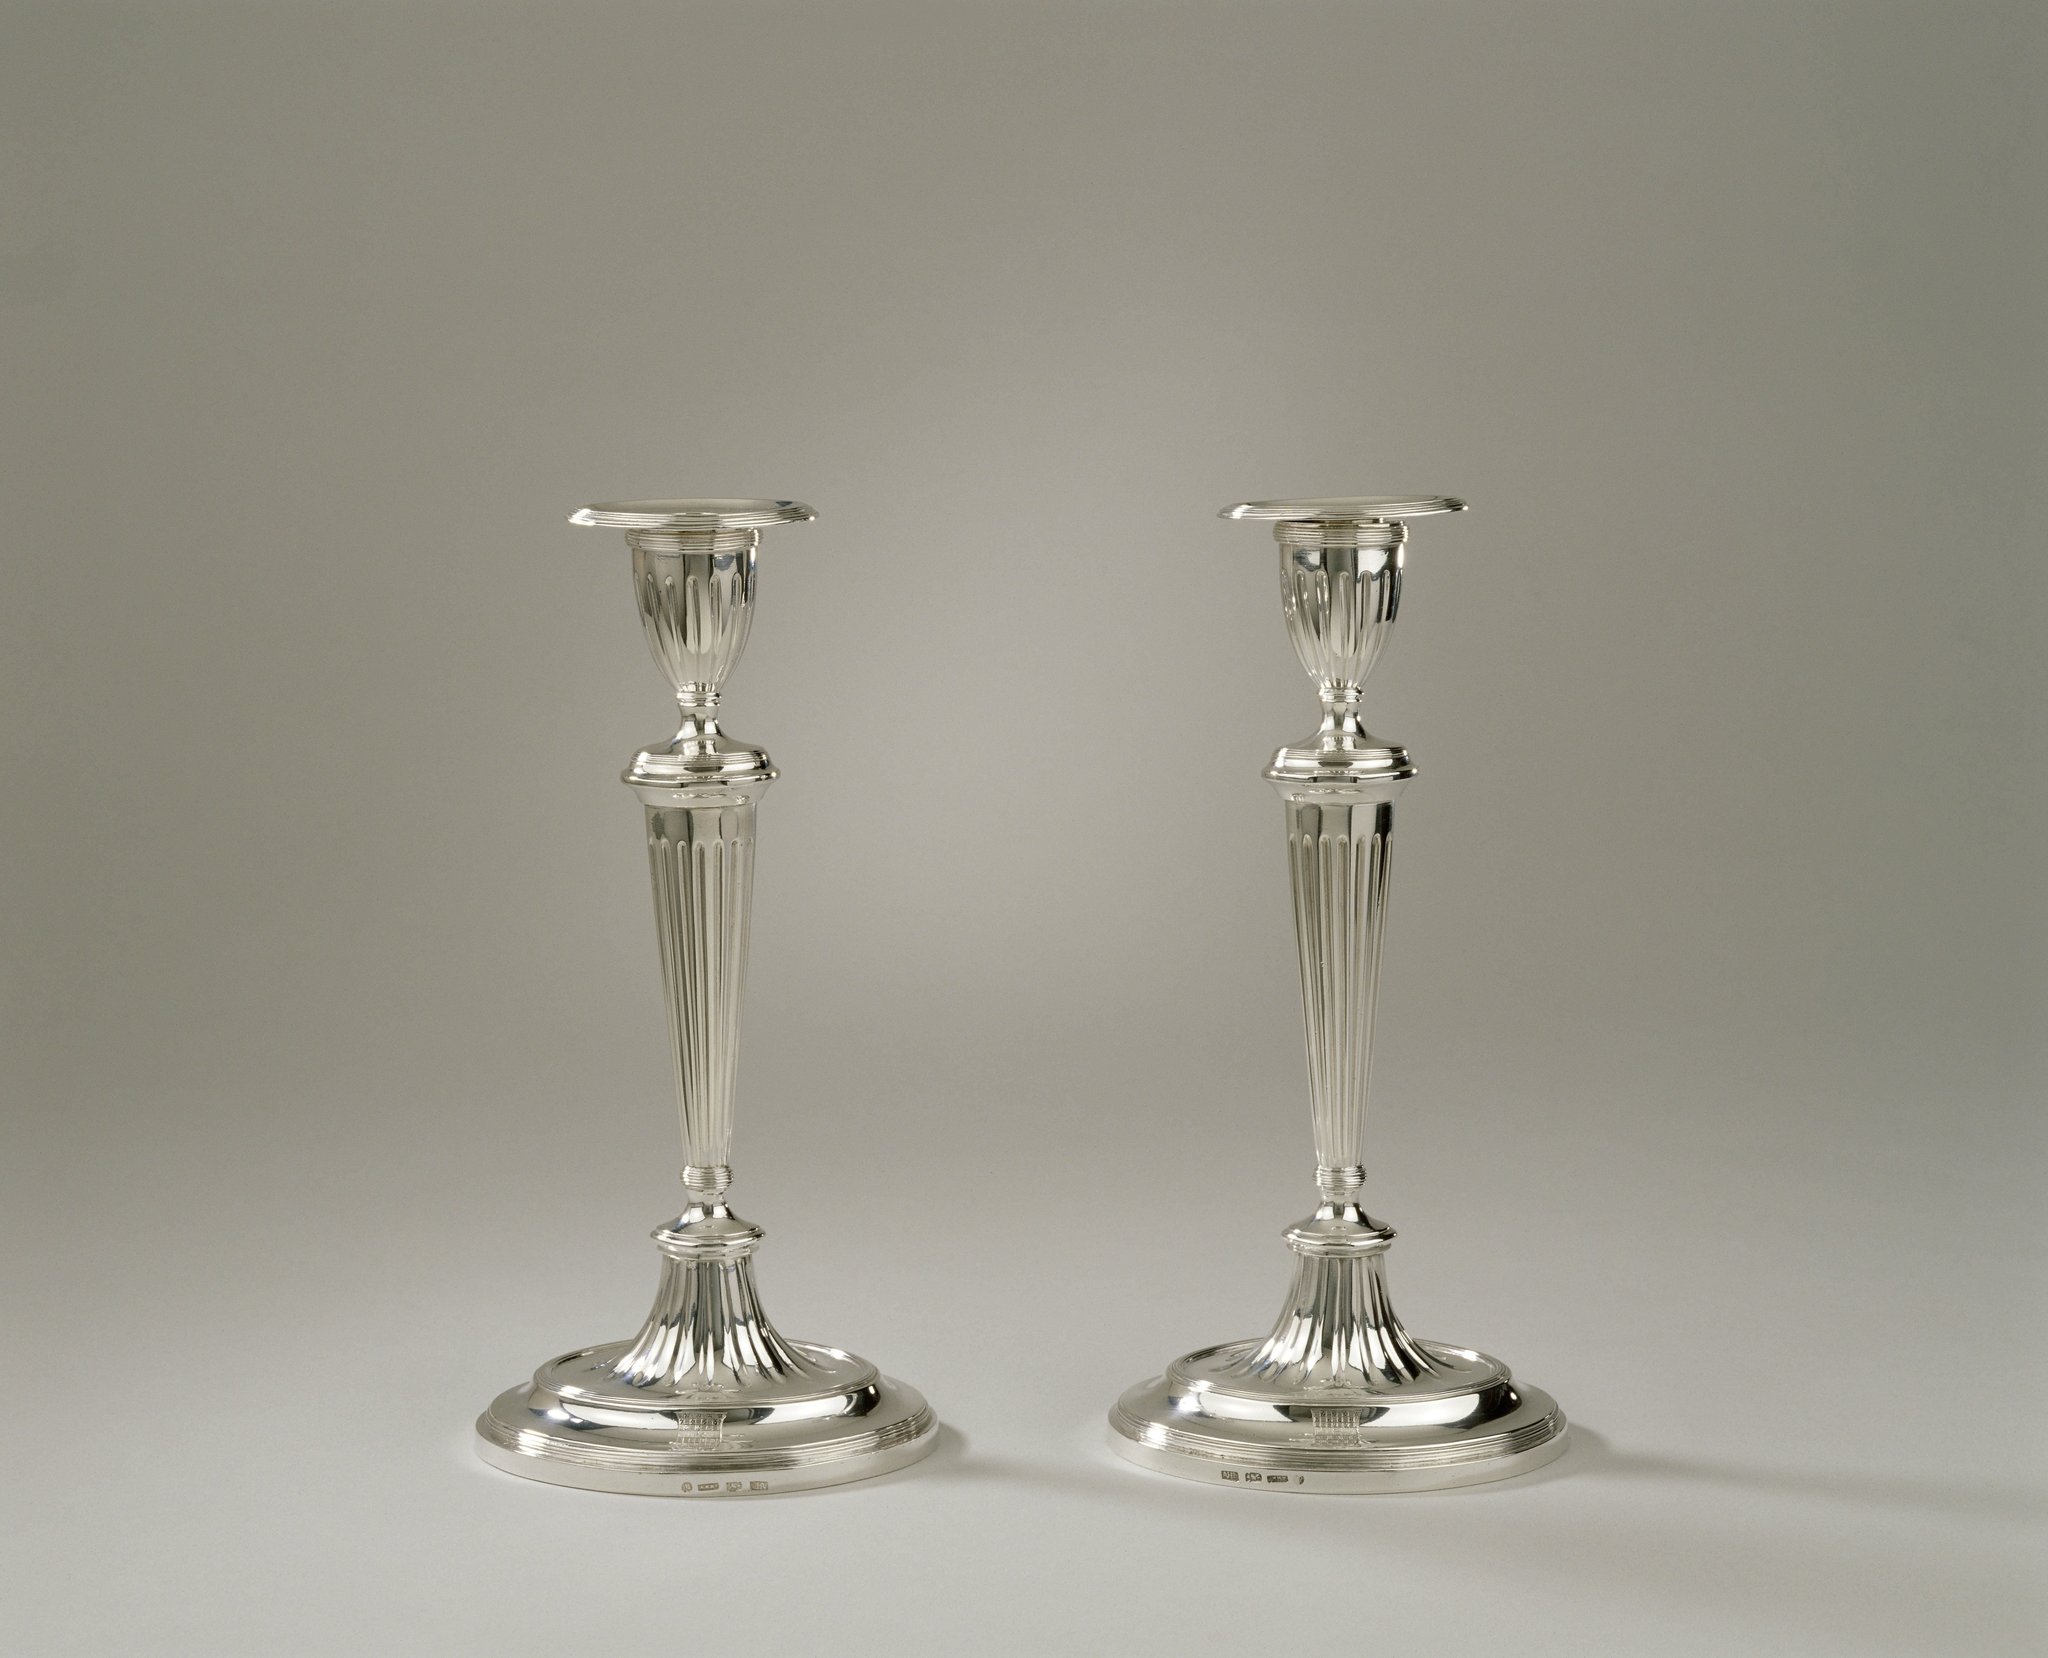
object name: candlestick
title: Kandelaar met het familiewapen Clifford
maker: anton hinrich pape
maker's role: silversmith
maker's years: 1746-1816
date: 1805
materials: silver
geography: amsterdam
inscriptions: town mark, maker's mark, alloy mark, date letter: ‘W’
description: Two candlesticks engraved with the arms of Jonkheer George Clifford (1769 - 1847). Silver, Amsterdam, 1805, by Anton Hendrik Paap.